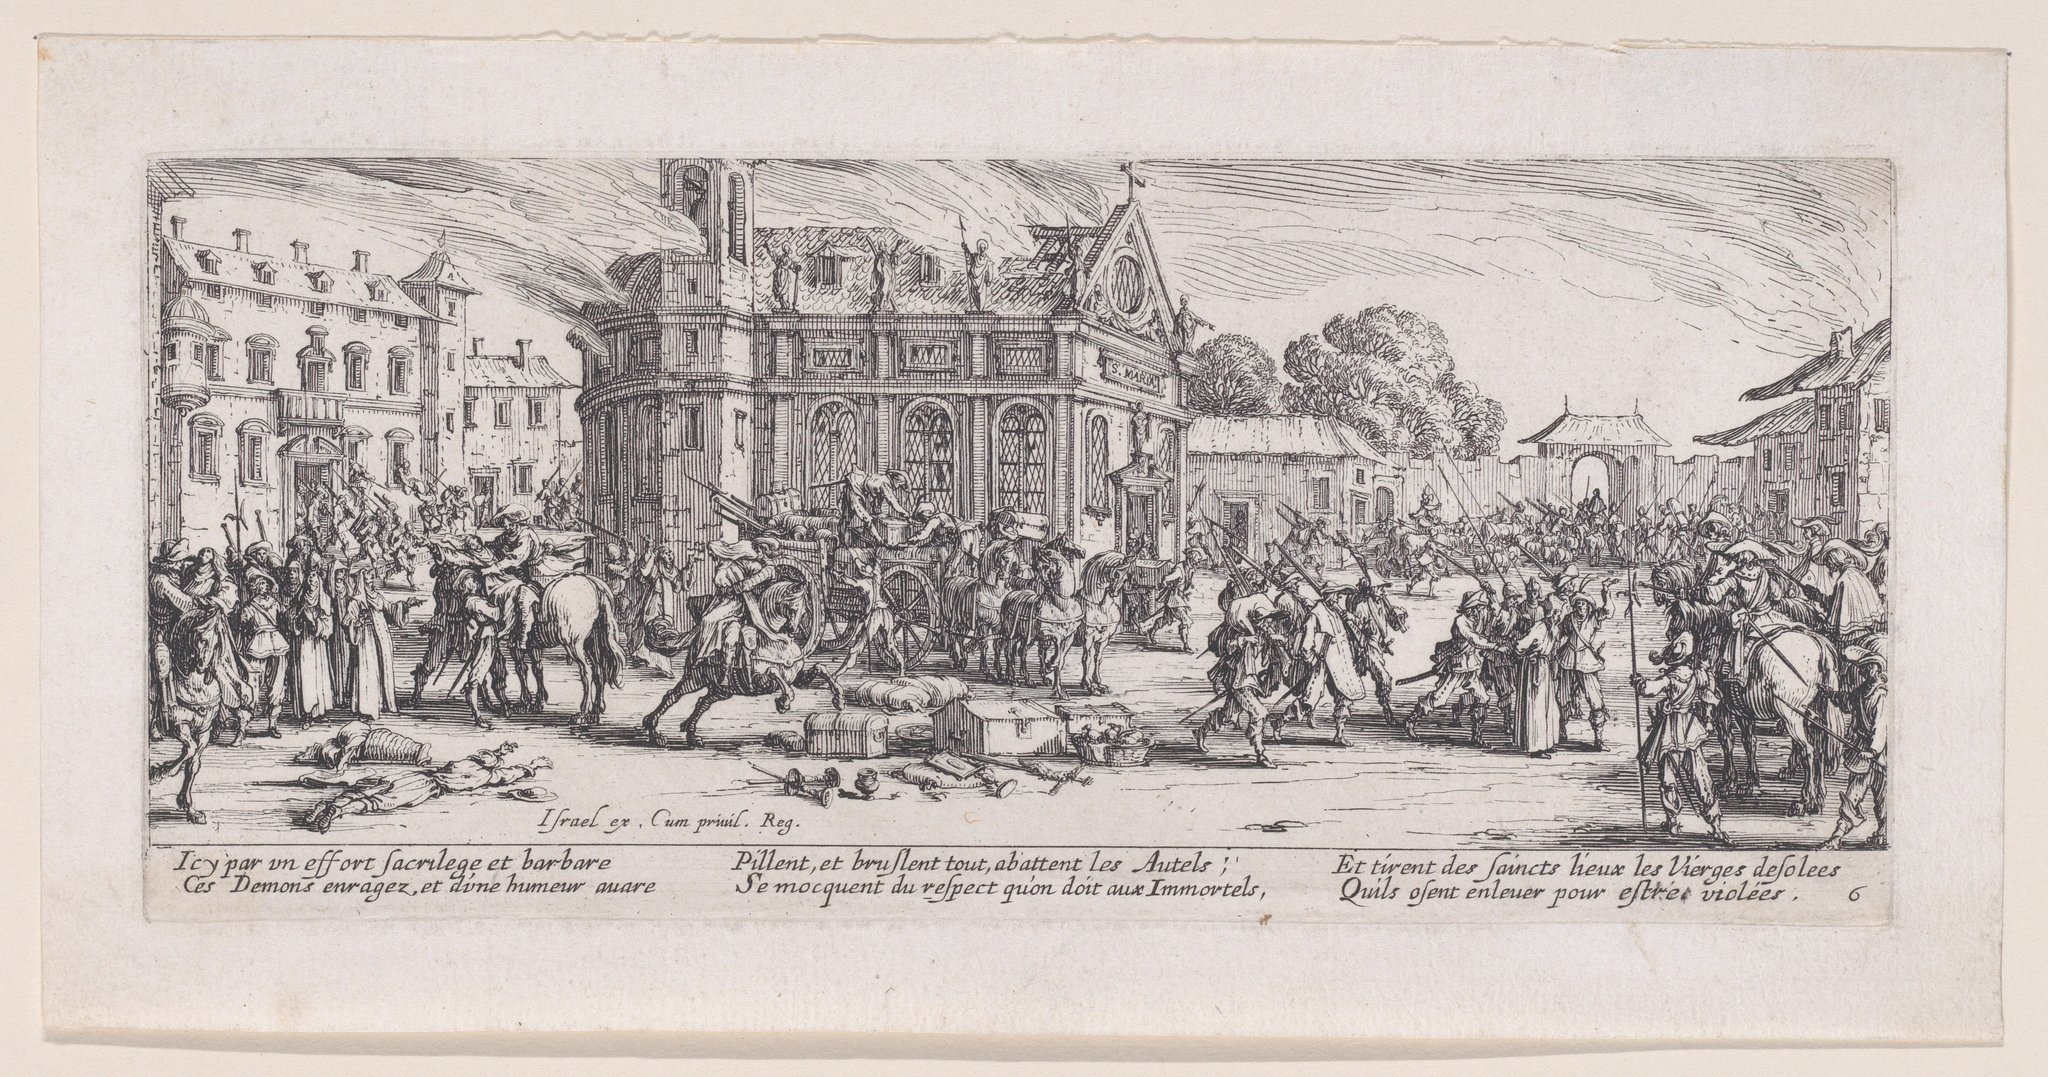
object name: print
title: Dévastation d'un Monastère (Devastation of a Monastery), from Les Misères et les Mal-Heures de la Guerre (The Miseries and Misfortunes of War), plate 6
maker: jacques callot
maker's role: artist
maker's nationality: french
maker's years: 1592-1635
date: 1633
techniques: etching